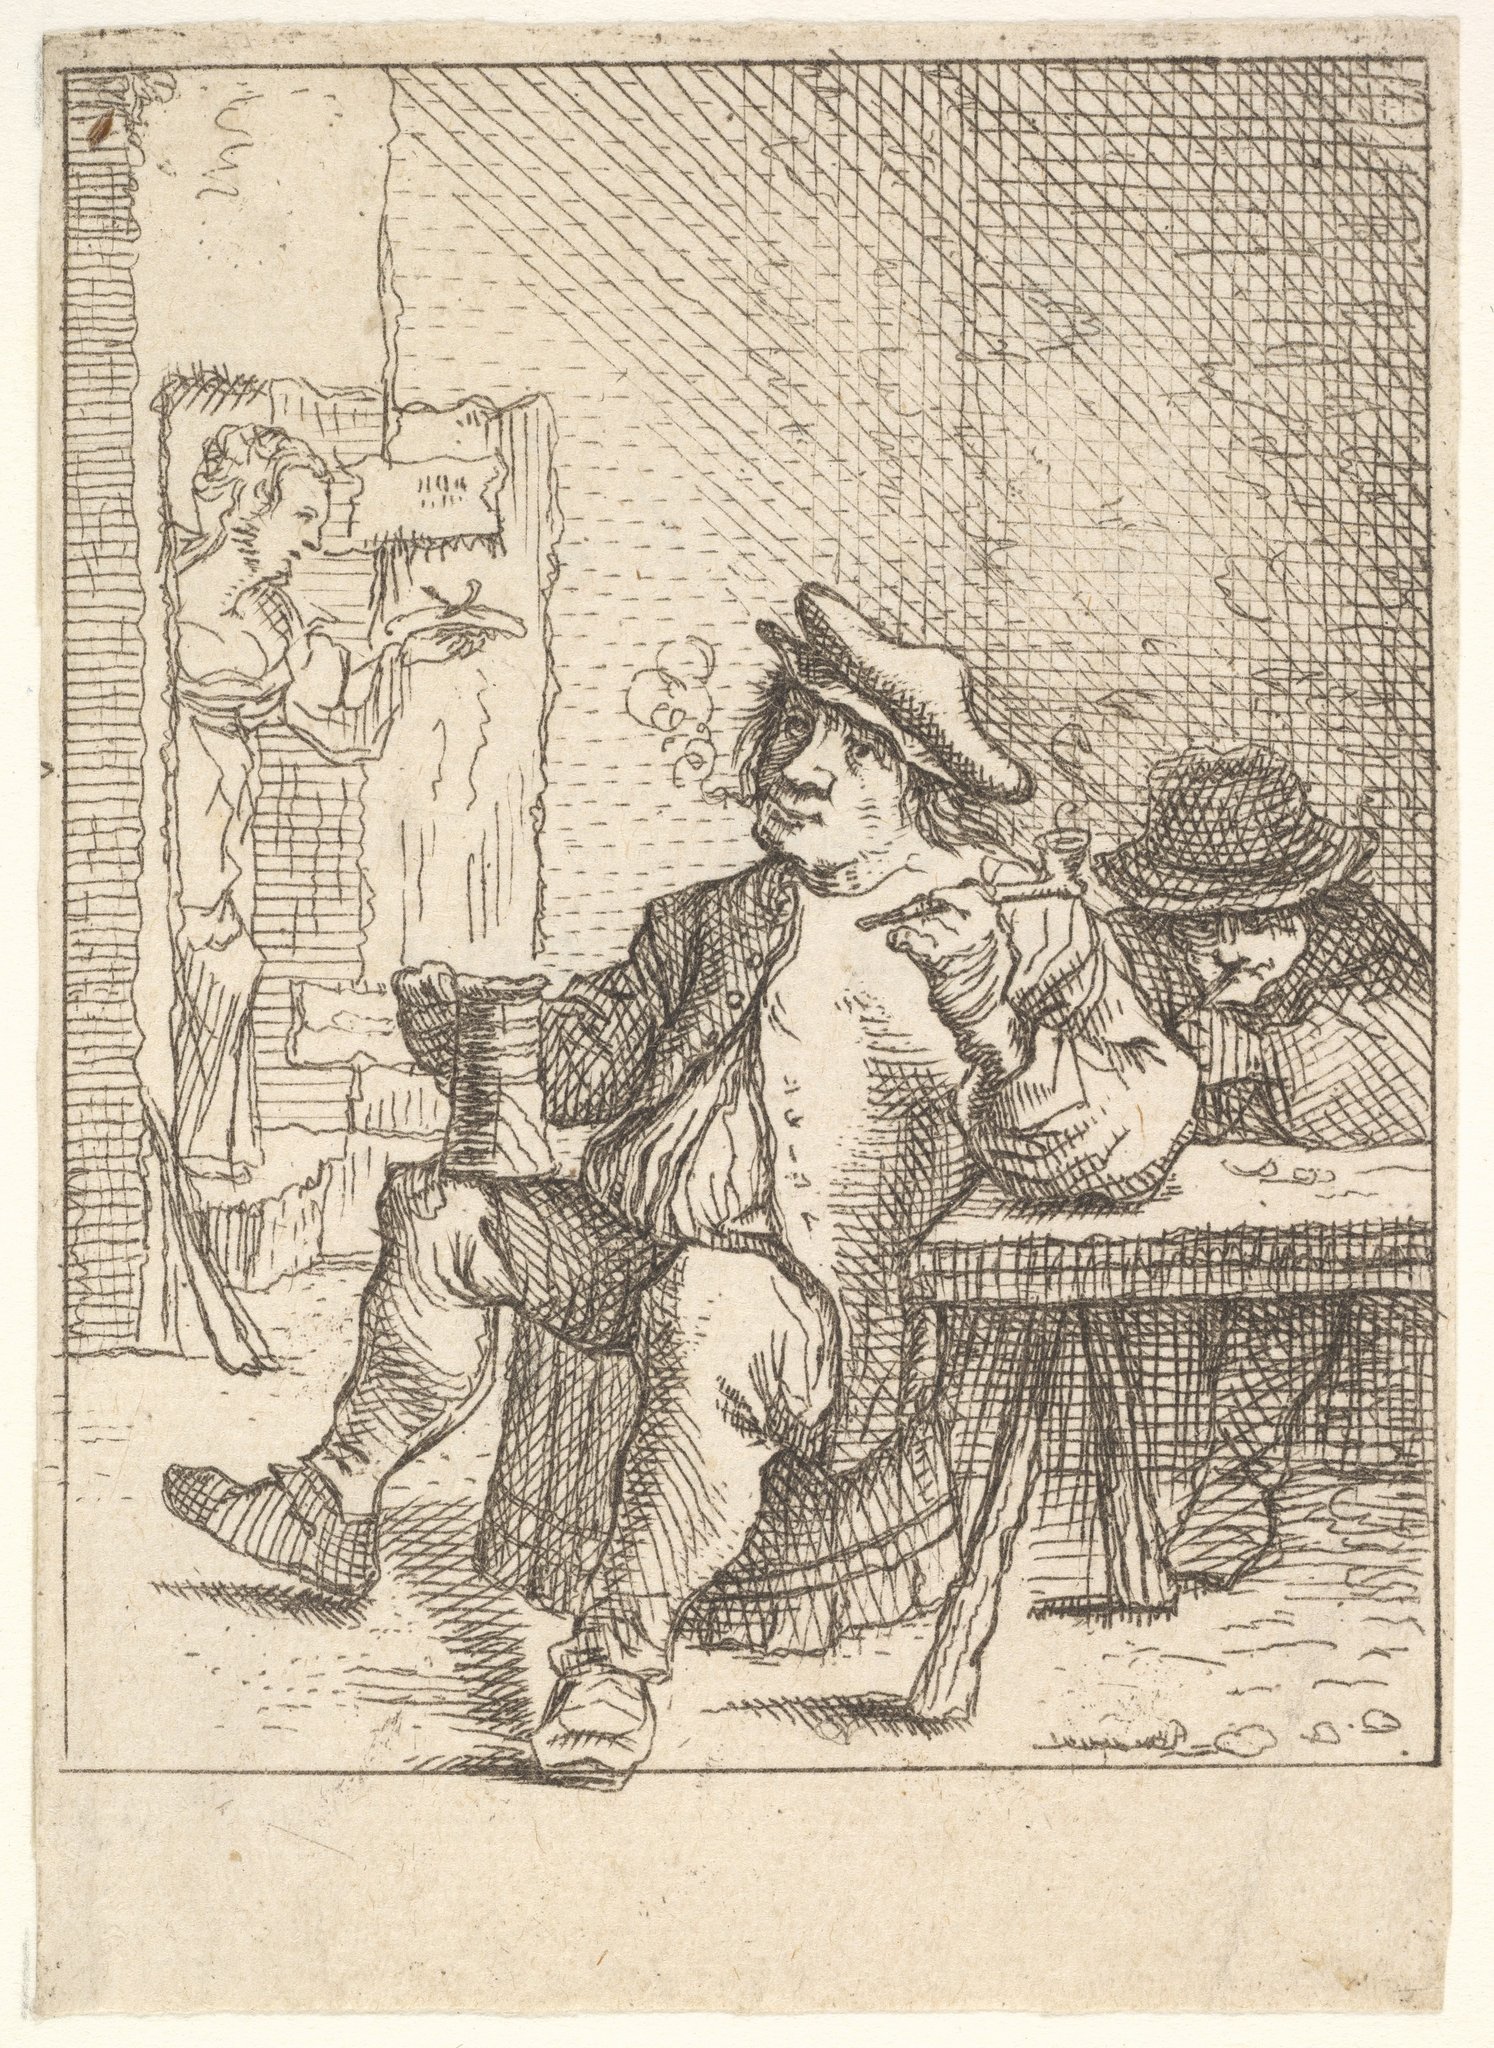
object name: print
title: Male peasant smoking a pipe and holding a drinking cup, his left elbow resting on a table, another man seated at the table, a waitress walking through a doorway beyond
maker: david teniers the younger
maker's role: artist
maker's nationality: flemish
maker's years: 1610-1690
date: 1625-1690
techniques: etching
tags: men,women,smoking,drinking